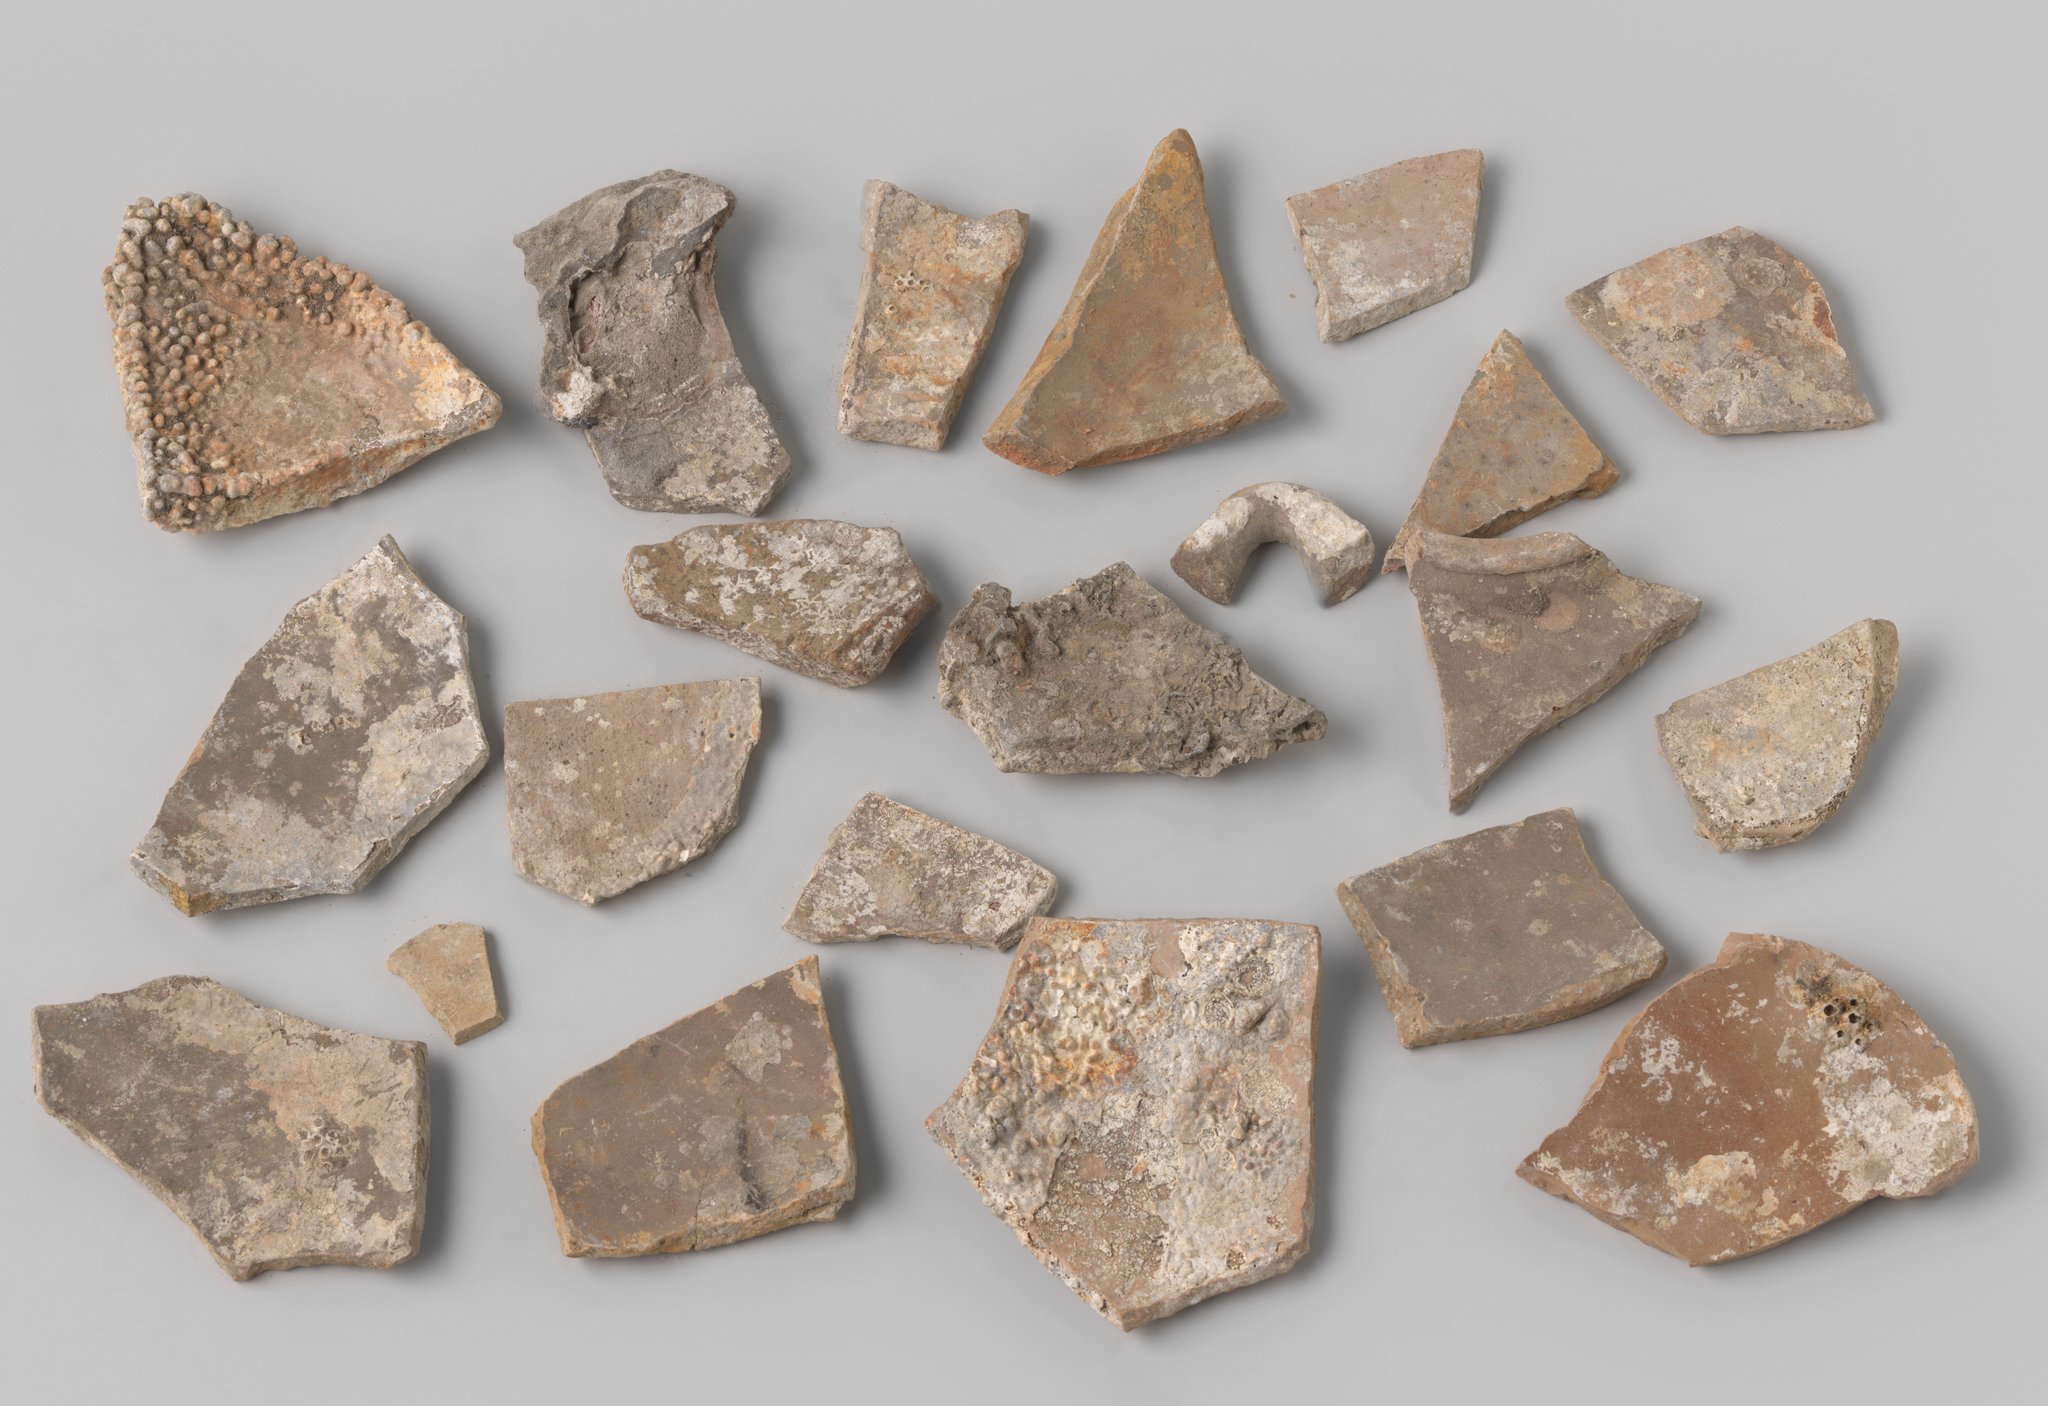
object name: sherd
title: Scherven van martavanen uit V.O.C.-schip de 'Witte Leeuw'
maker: Anonymous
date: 1613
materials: porcelain, stoneware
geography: southeast asia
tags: verenigde oostindische compagnie, sint-helena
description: A jar. The interior and exterior is covered by a dark grey and reddish glaze. The base and lower part of the waist is unglazed and has a yellow surface. There is a grey-yellow band on the shoulder, a few centimeters beneath the ears, where the glaze has come off due to another jar having been placed over this one during firing process.